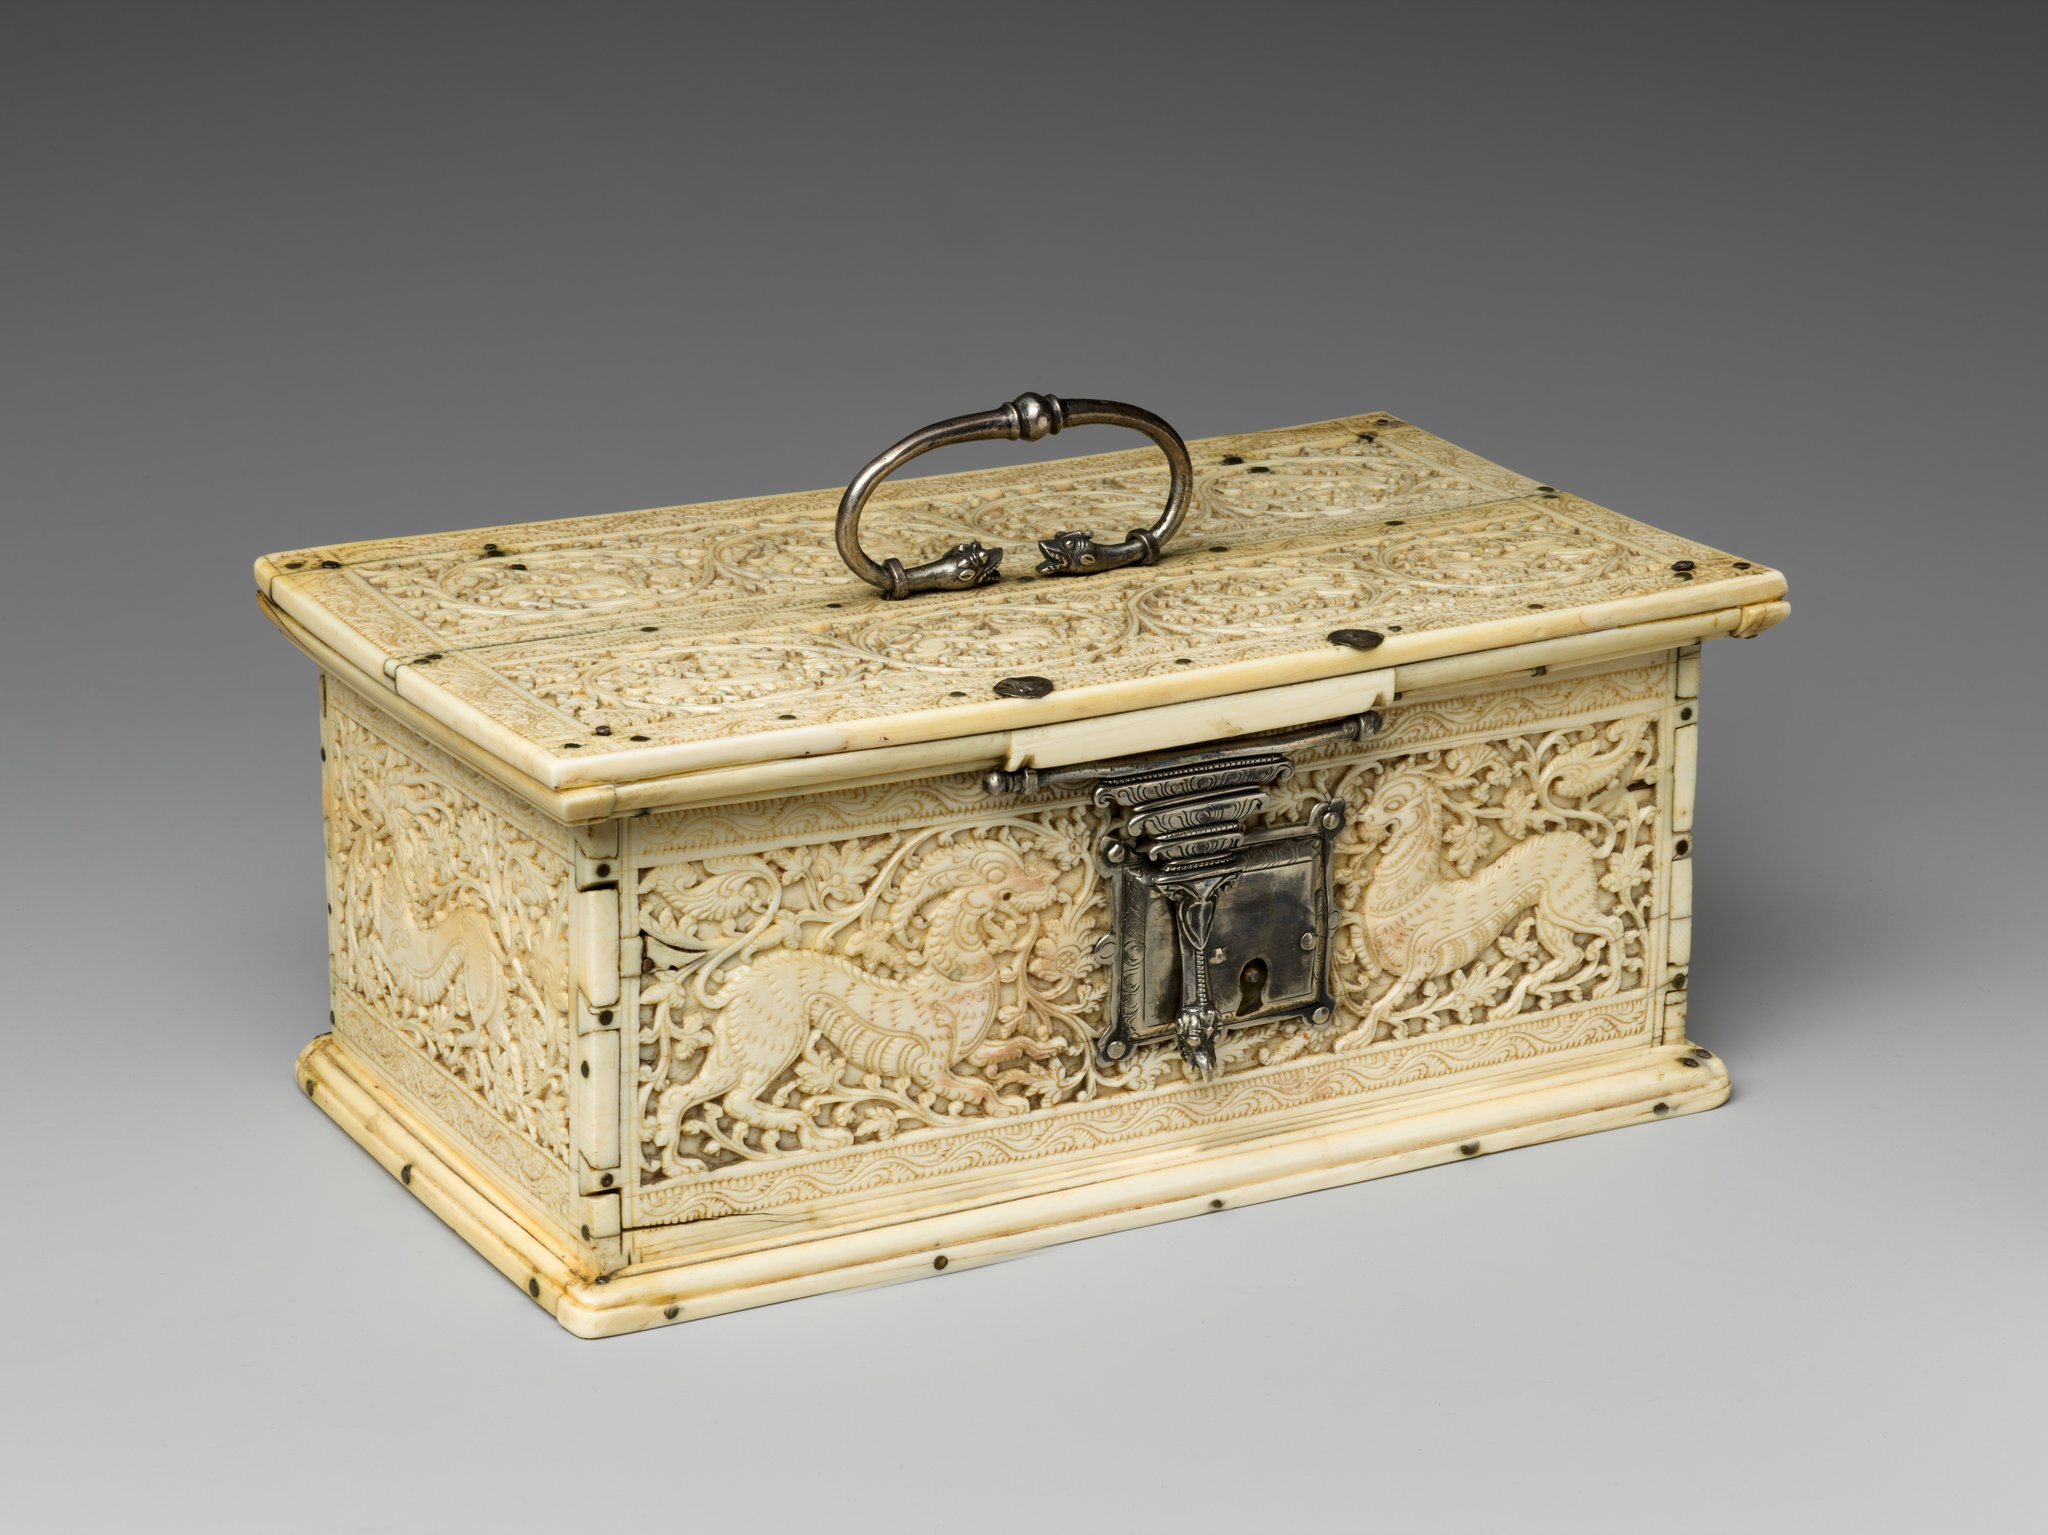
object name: casket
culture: sri lankan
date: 1551-1600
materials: brass, ivory, silver